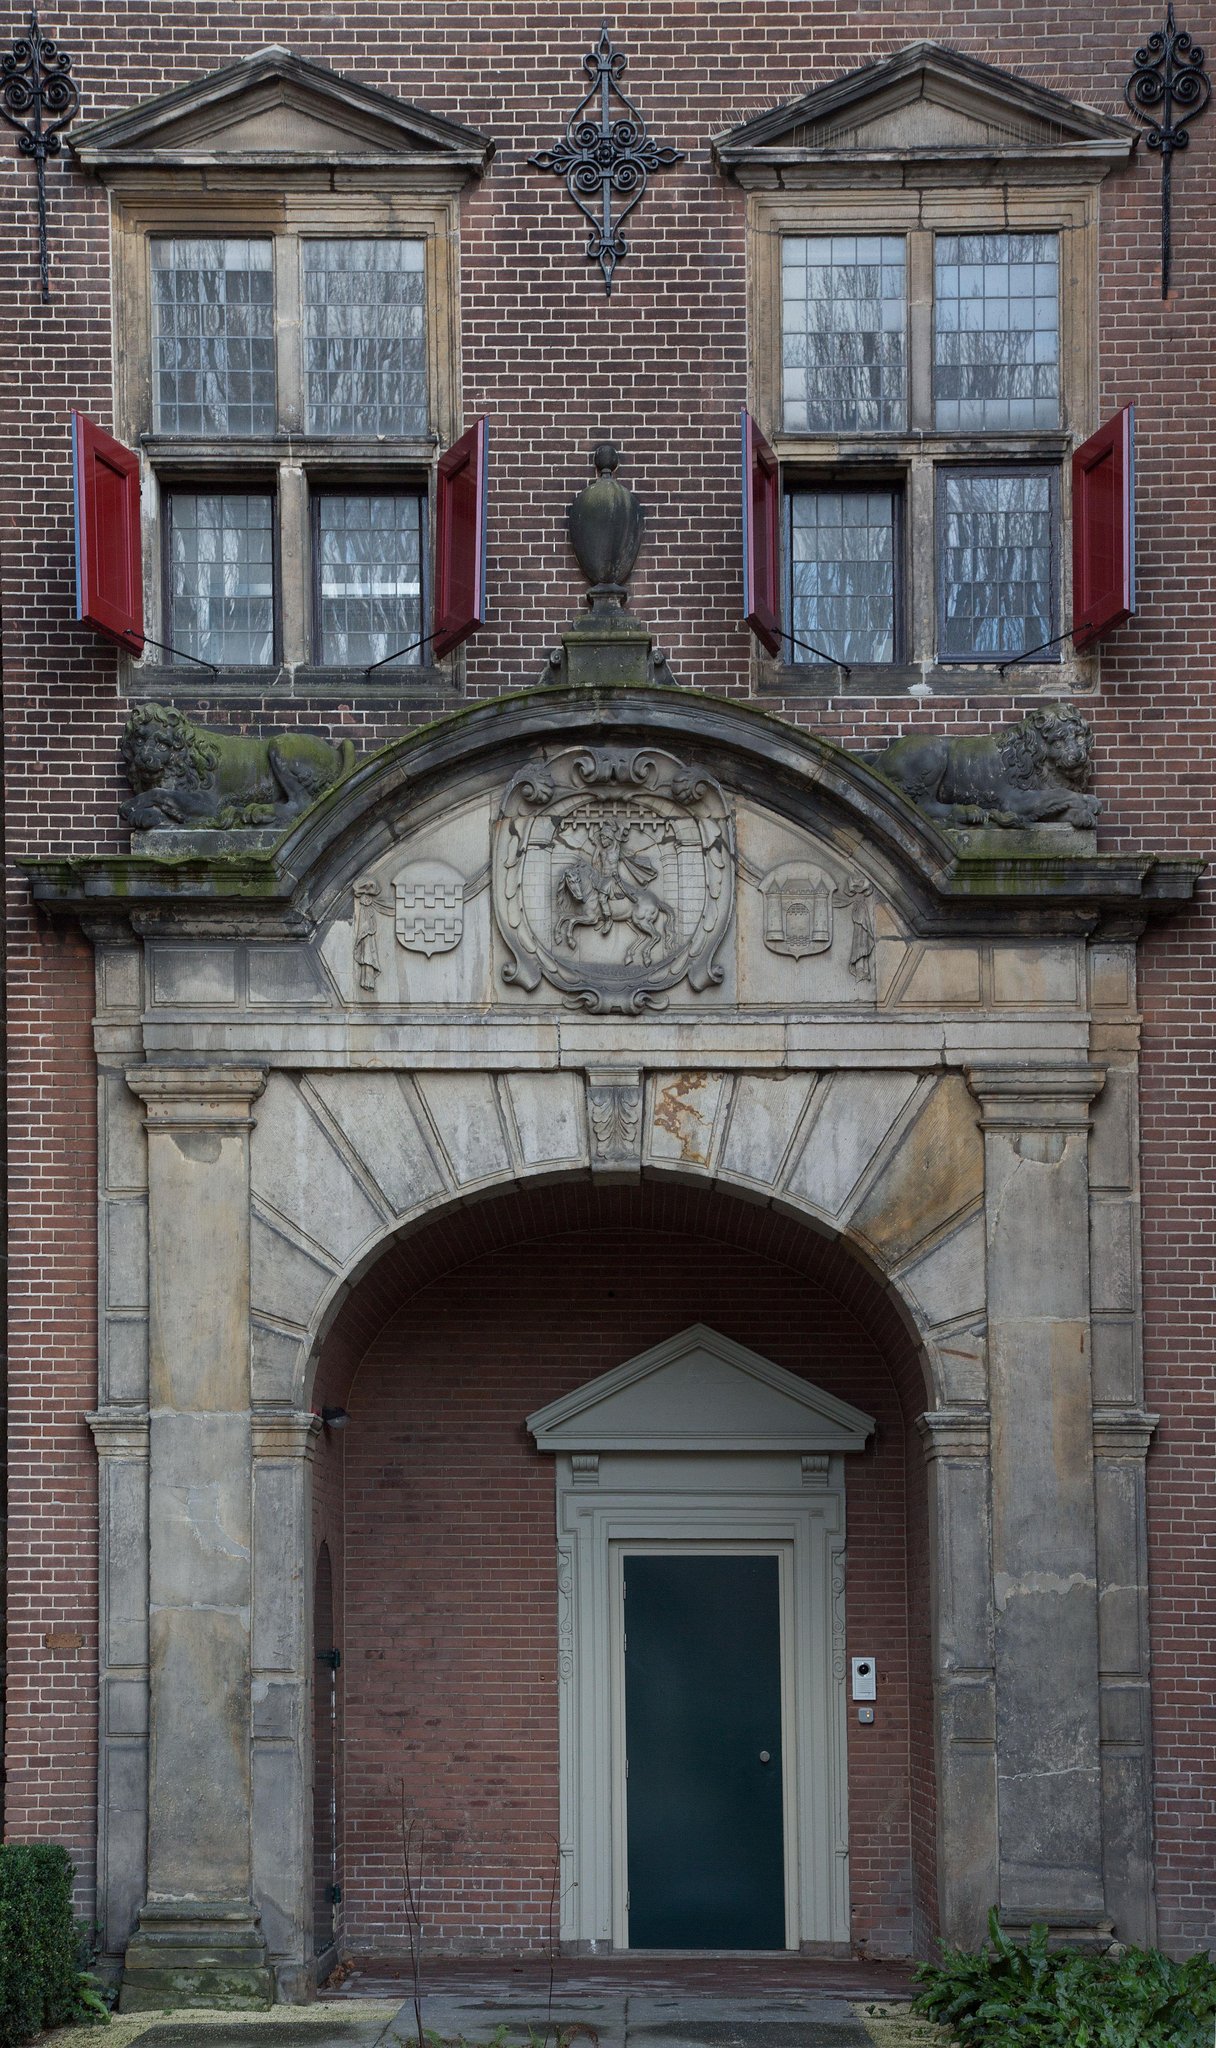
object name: architectural element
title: Bouwfragment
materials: stone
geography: gorinchem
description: Steenhouwwerk van de gevel (stadzijde) van de Waterpoort te Gorinchem, bestaande uit steenstukken en drie stuks gevelankers.